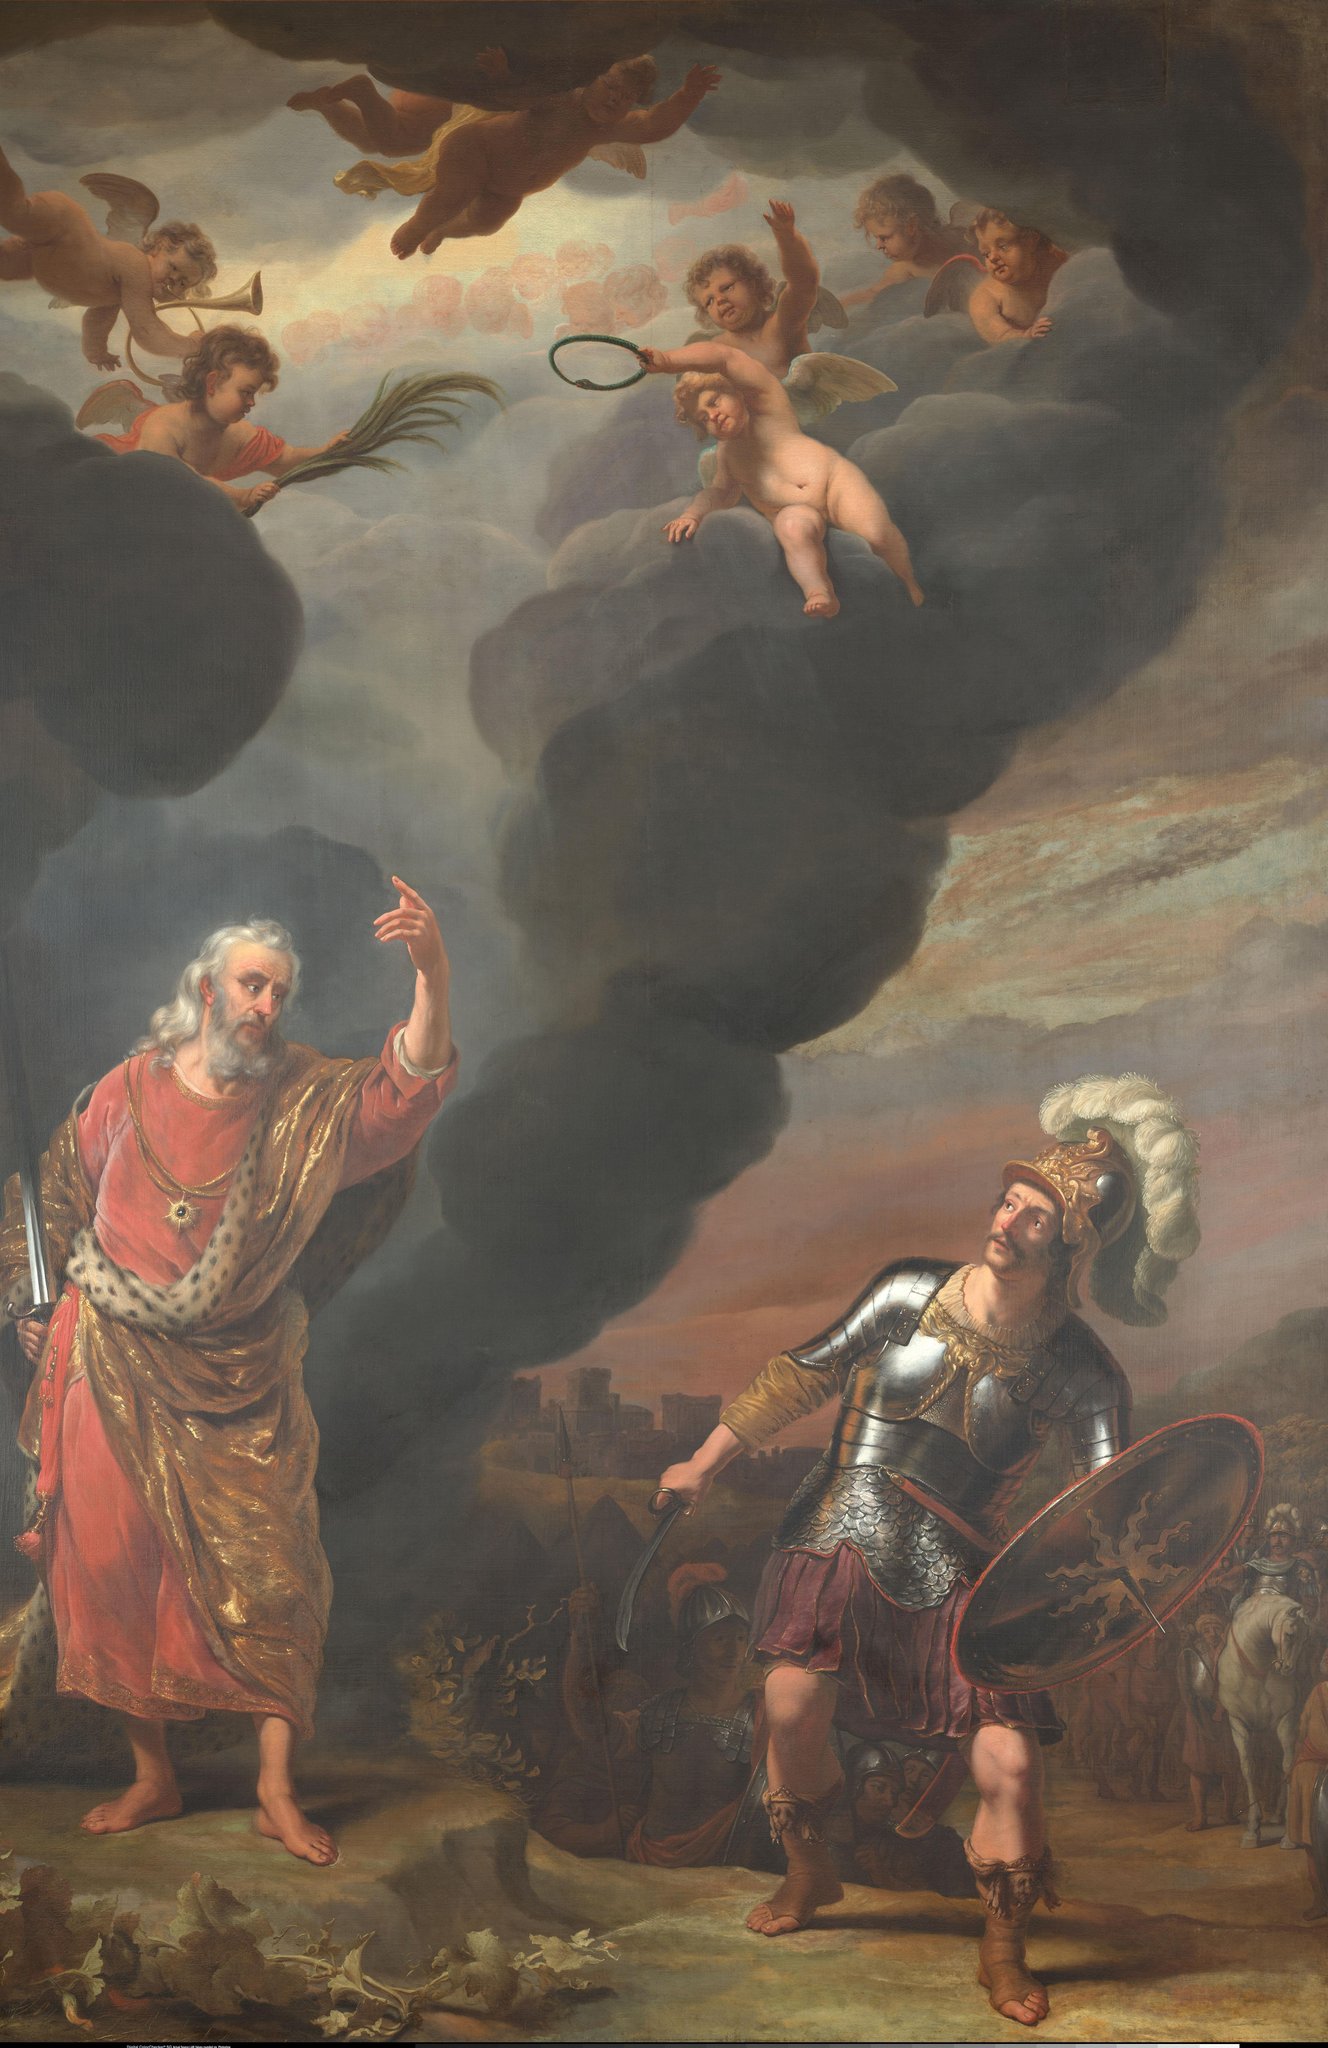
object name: painting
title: The Captain of God's Army Appearing to Joshua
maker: ferdinand bol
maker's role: draughtsman, painter, print maker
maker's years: 1616-1680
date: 1660-1663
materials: canvas, oil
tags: the fall of jericho (joshua 6)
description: Koning Amazia en de man Gods. De 'Vorst van het Heir des Heeren' verschijnt aan Jozua bij Jericho. Boven opent zich de hemel met engeltjes, waarvan er één een slang vasthoudt die in zijn staart bijt, het symbool van de eeuwigheid. Jozua gekleed in wapenrusting met een zwaard en schild in de handen. Onderdeel van een groep van vijf werken vervaardigd voor het huis aan de Nieuwegracht 6 te Utrecht.